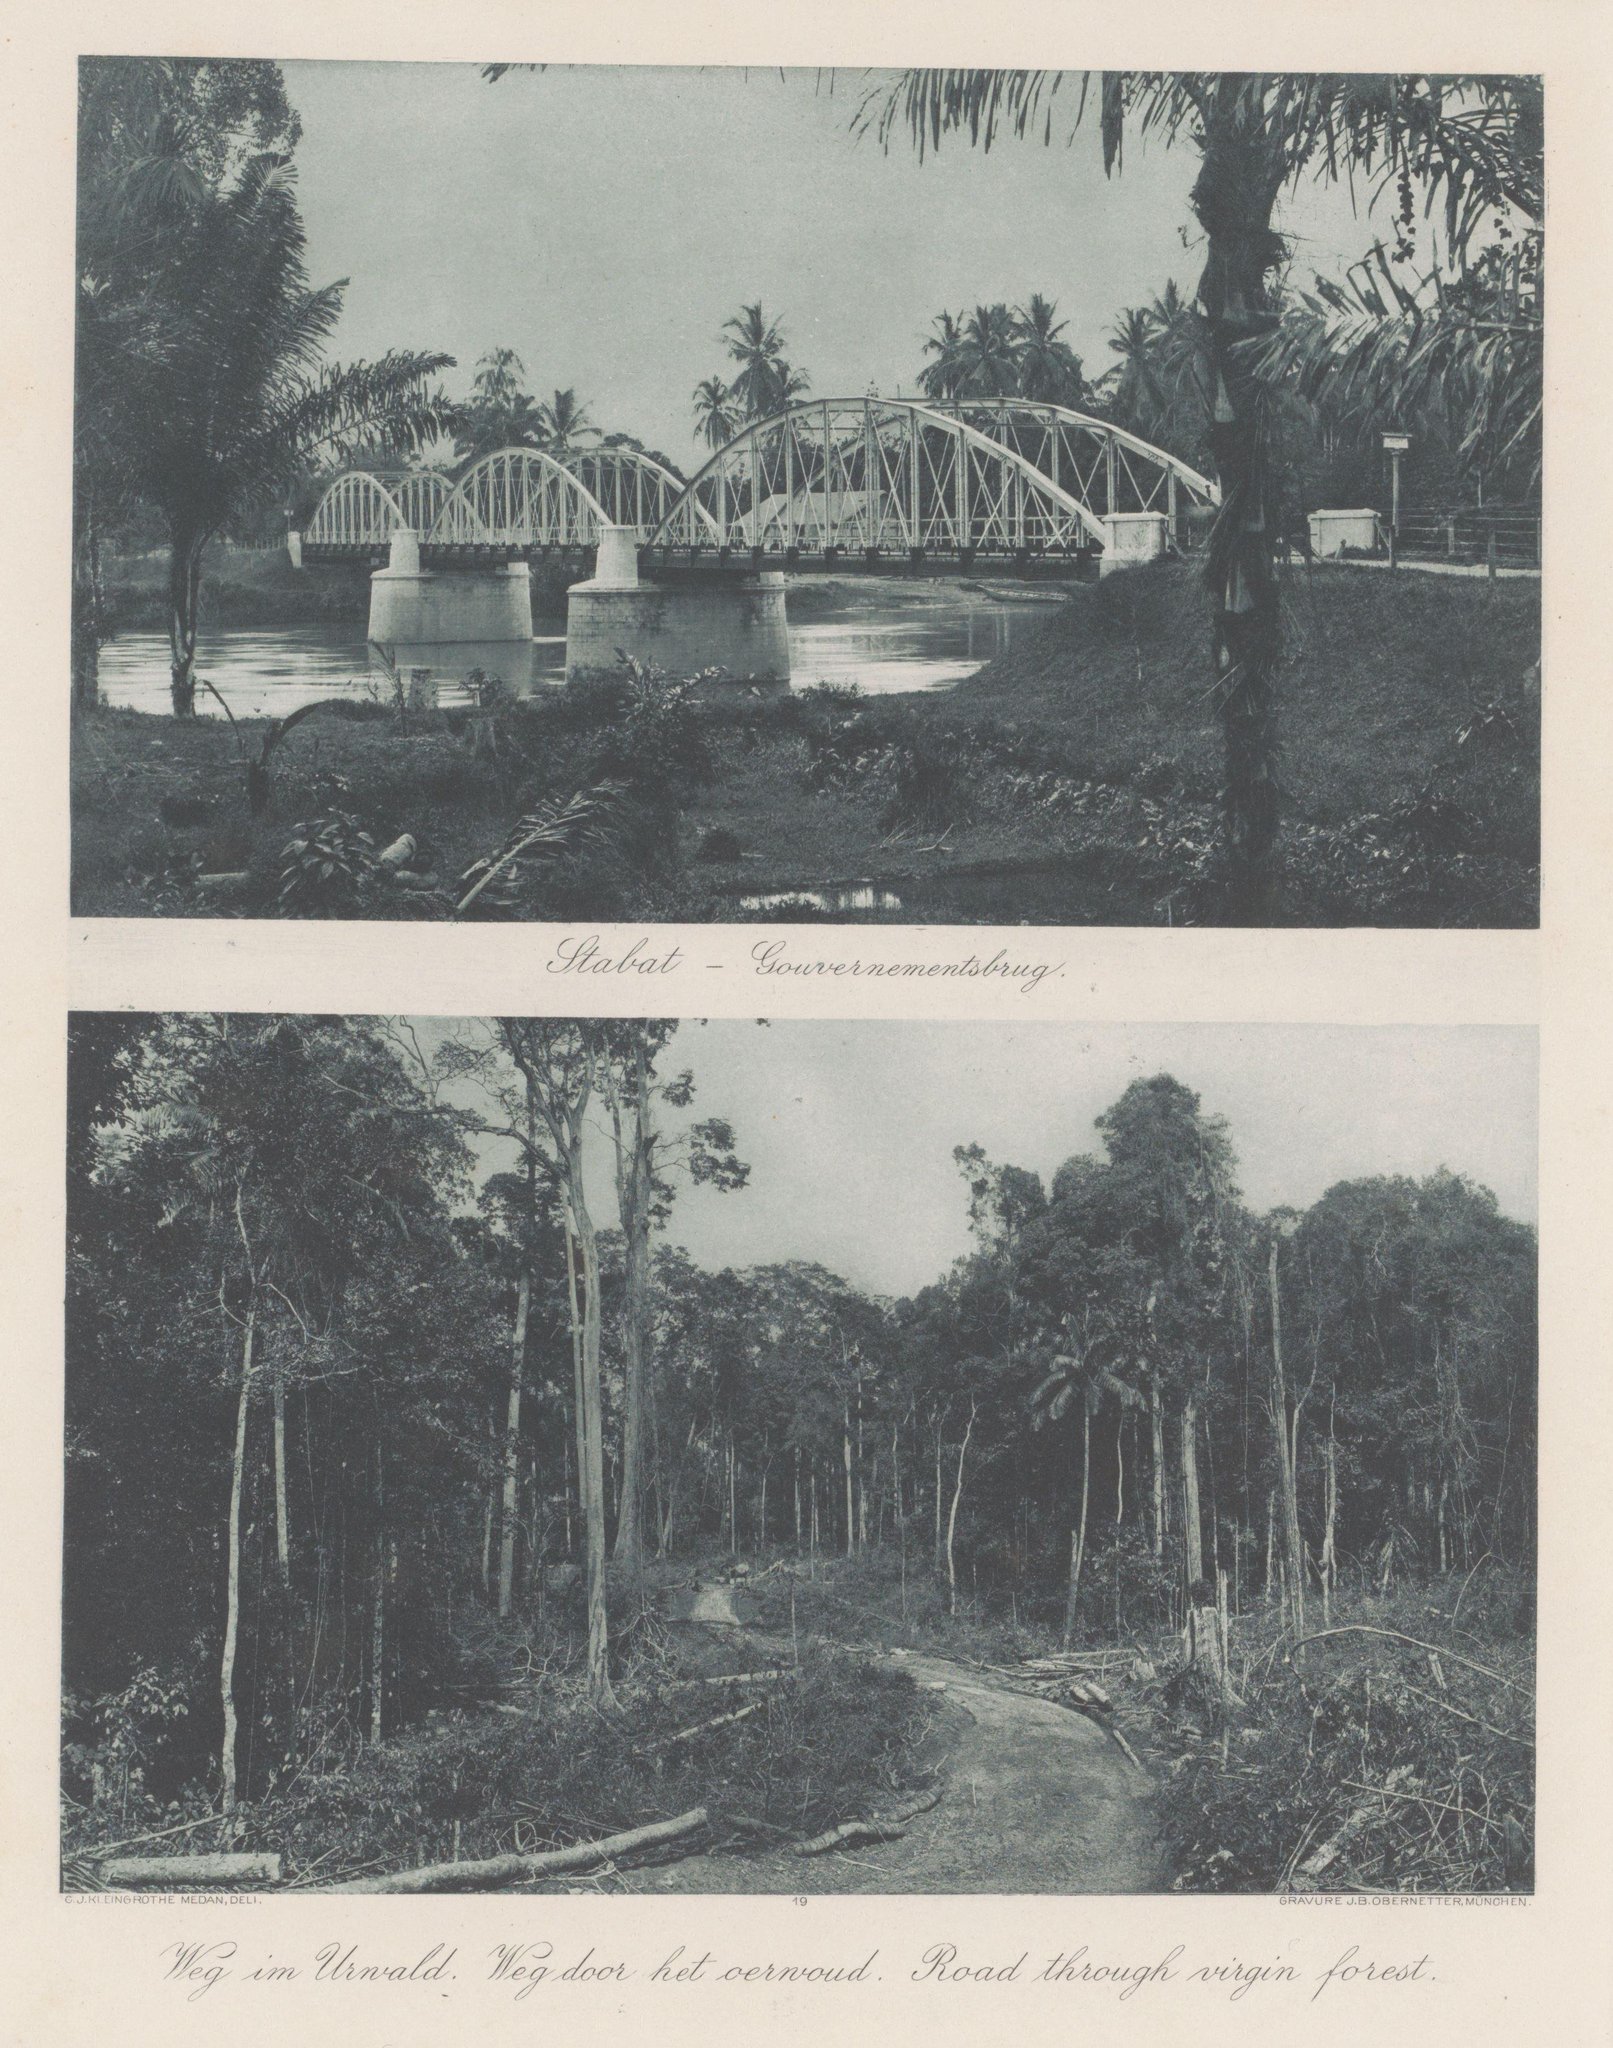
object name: photomechanical print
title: Stabat - Gouvernementsbrug (boven), Weg door het oerwoud (onder)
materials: paper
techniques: photoaquatint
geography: sumatra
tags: clearing ~ forest, landscape with bridge, viaduct or aqueduct, road, path, sumatra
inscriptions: number: ‘19’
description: Onderdeel van Album met heliogravures van Sumatra's oostkust.